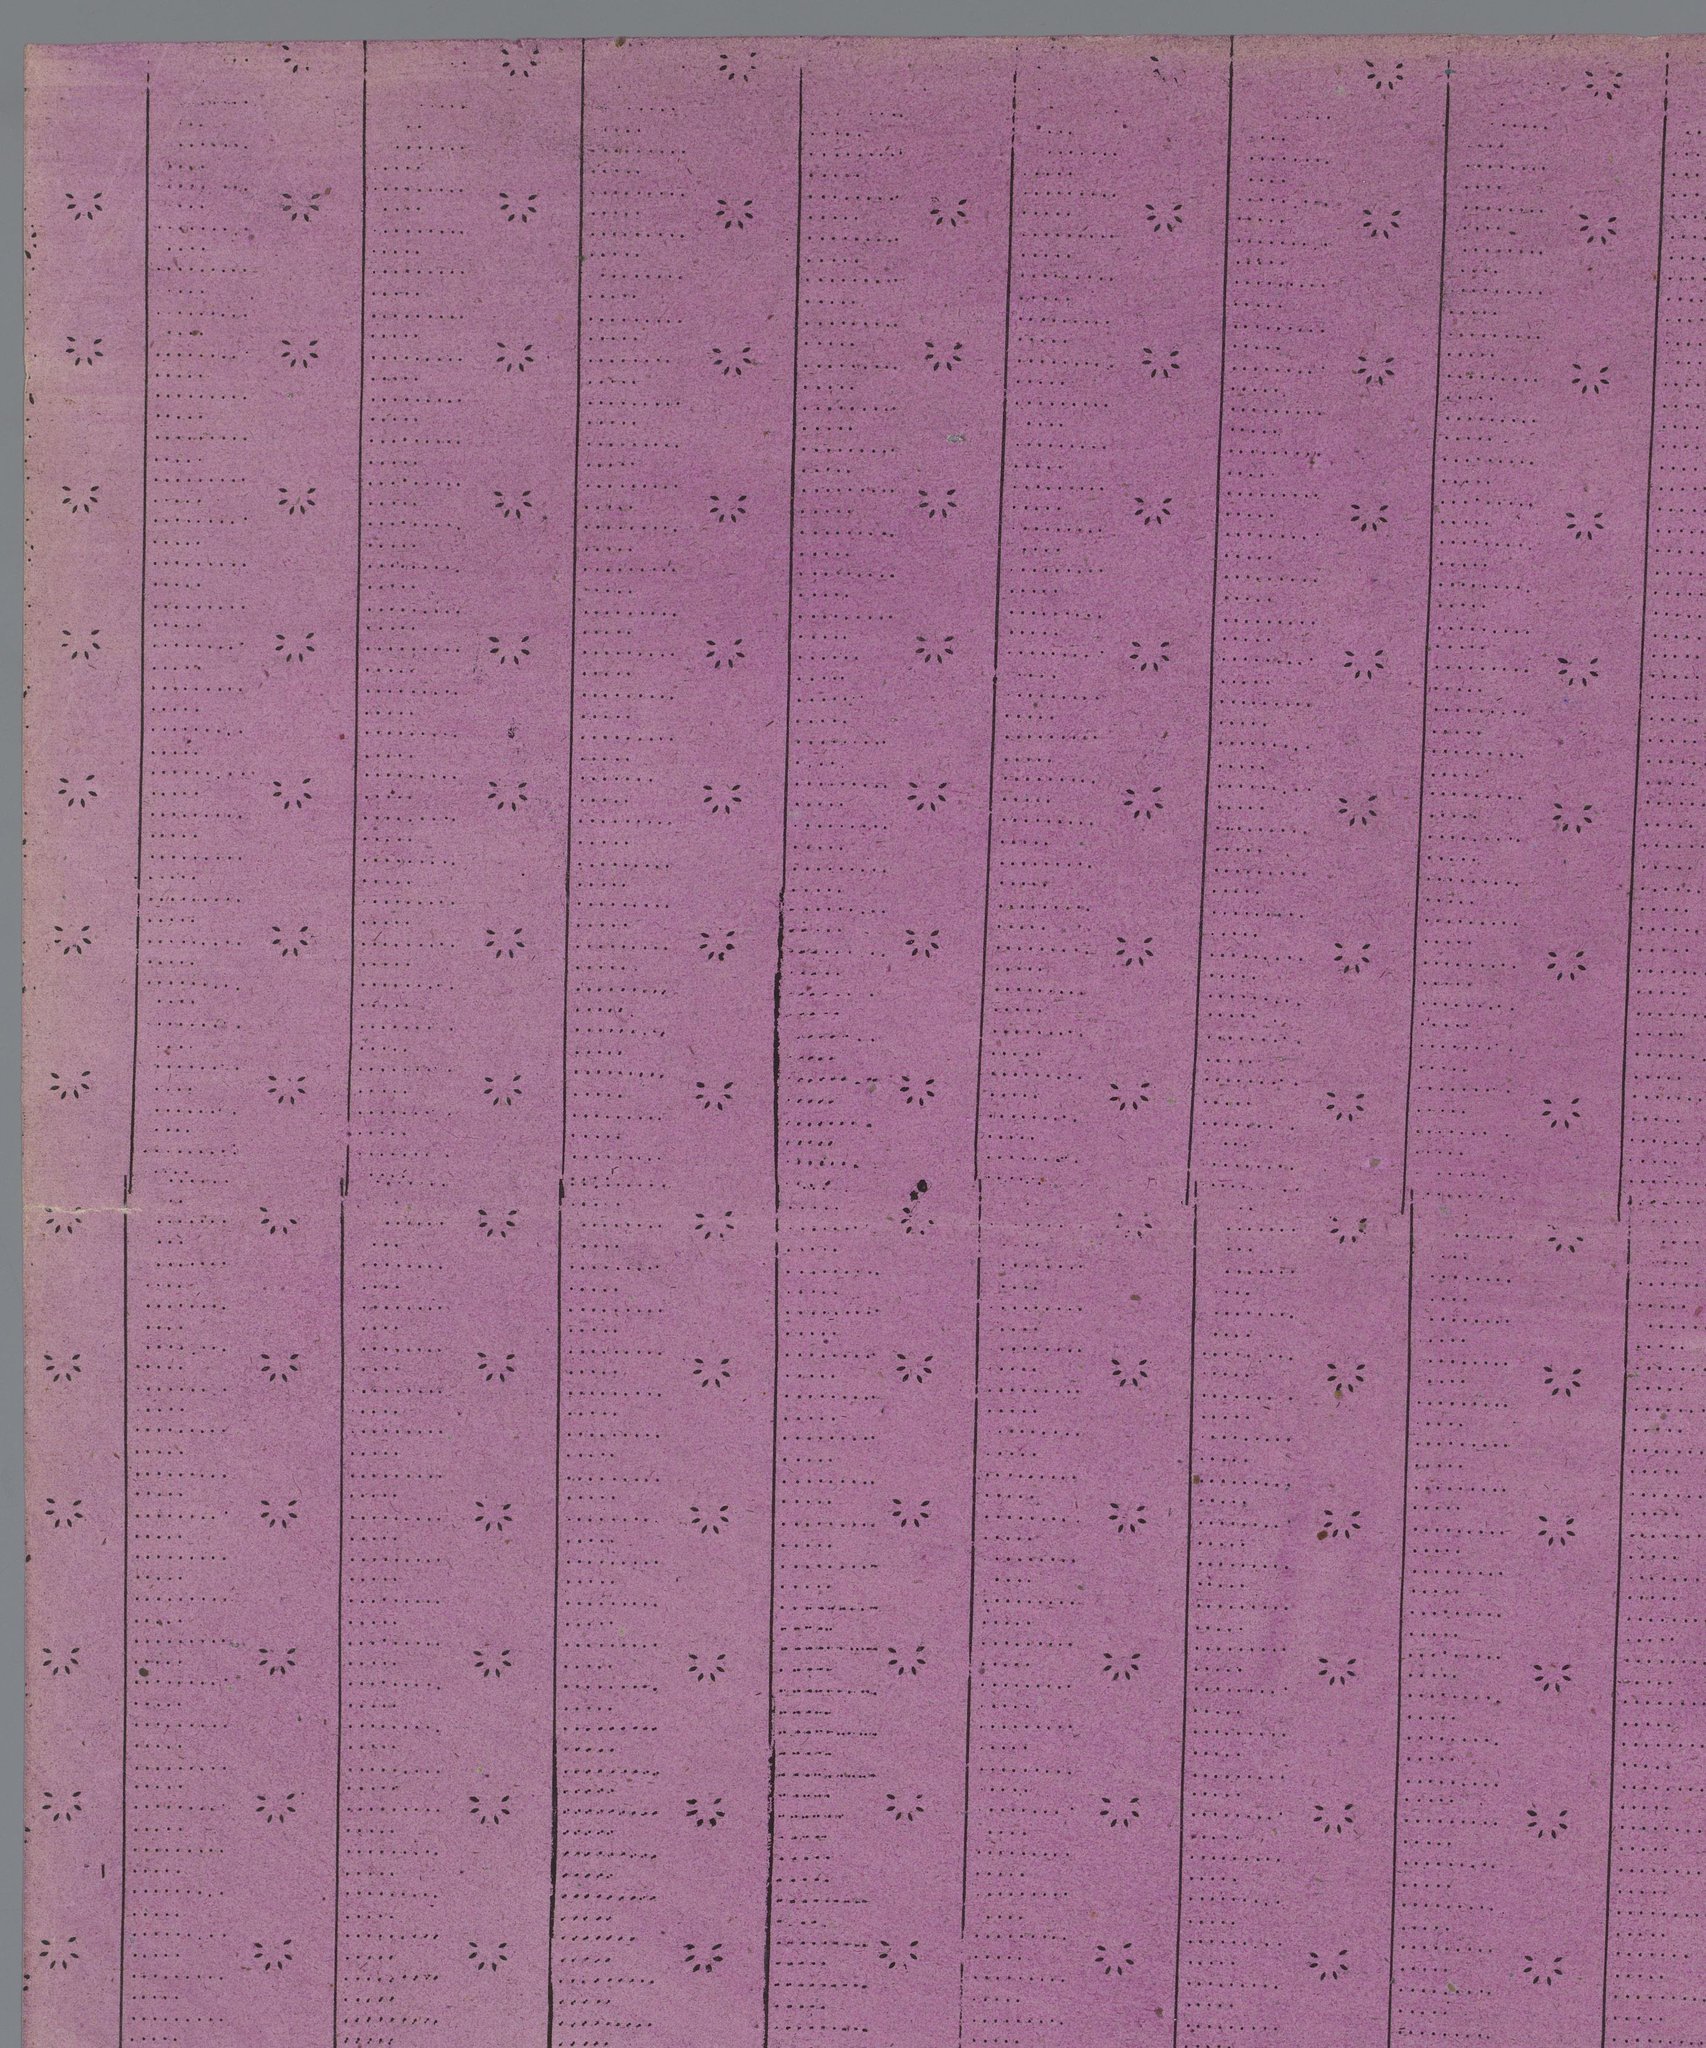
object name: printed paper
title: Blad met banenpatroon van lijnen en stippen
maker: Anonymous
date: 1850-1950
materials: lacquer, paint, paper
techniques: printing block, lacquer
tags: ornament ~ geometric motifs, ornament derived from plant forms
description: Blad met verticaal banenpatroon van lijnen, stippen en zeer gestileerde bloemen.